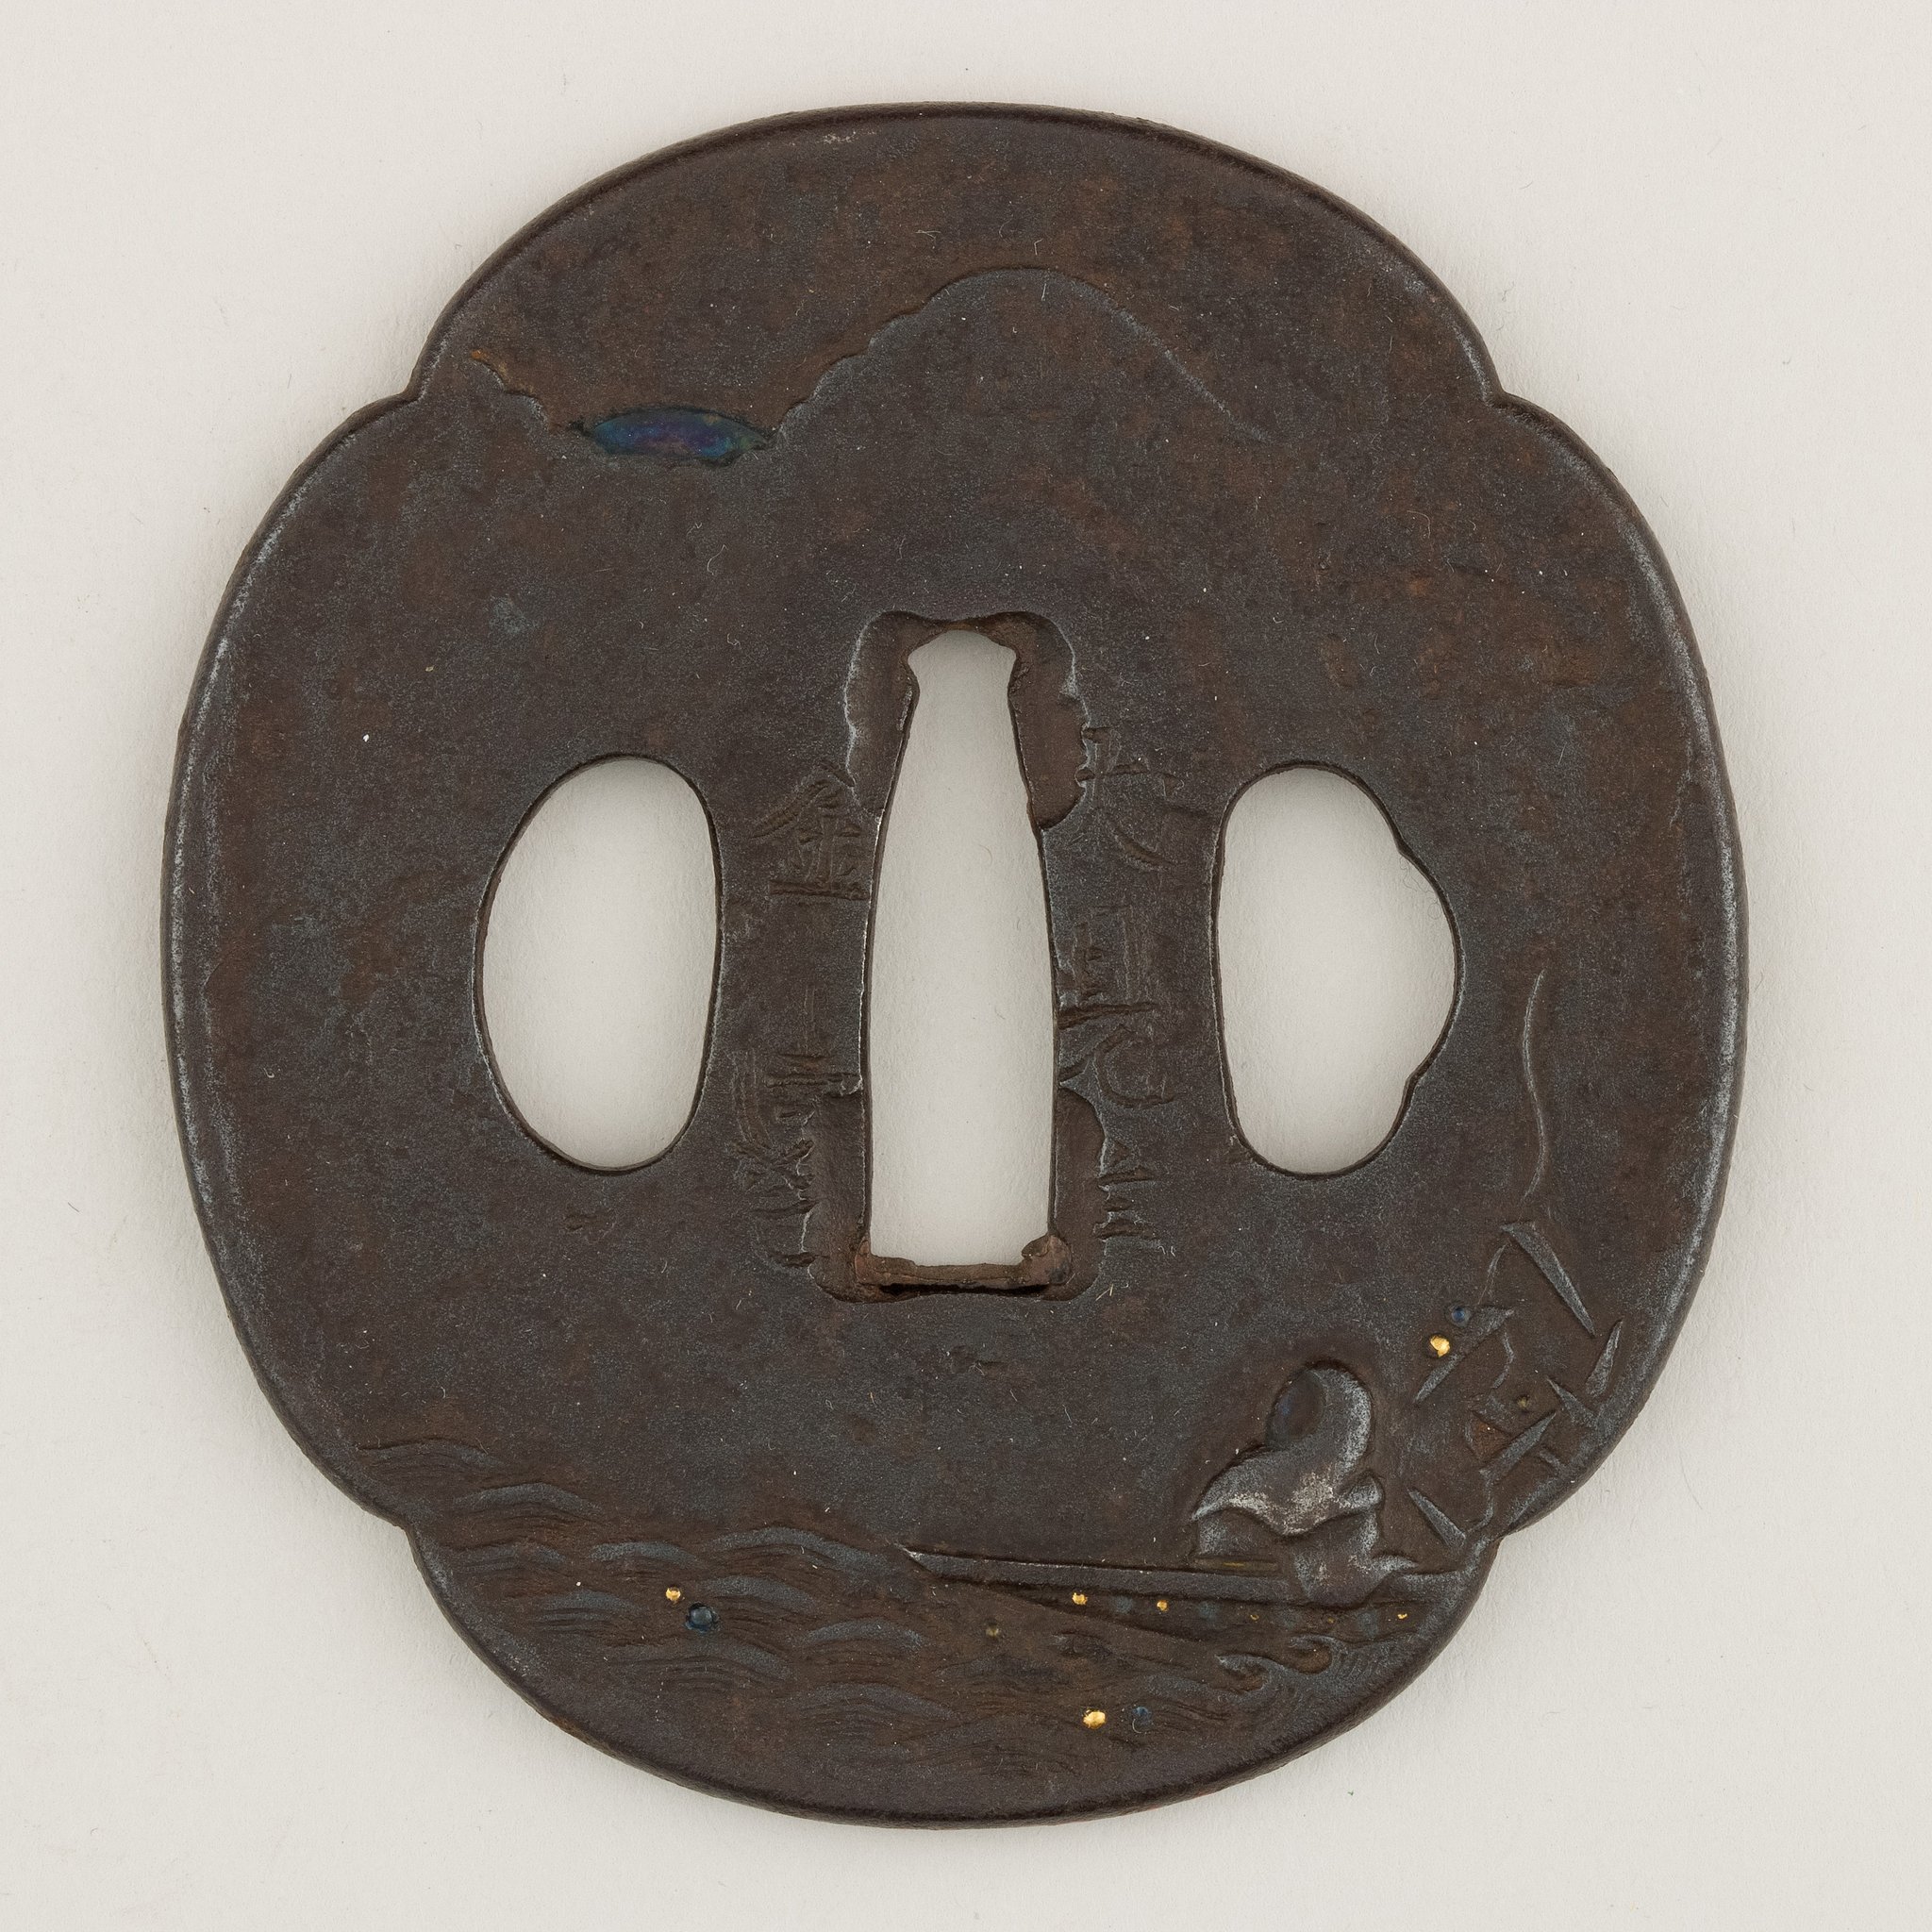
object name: sword guard tsuba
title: Sword Guard (Tsuba)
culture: japanese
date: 1601-1800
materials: gold, iron, silver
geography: japan